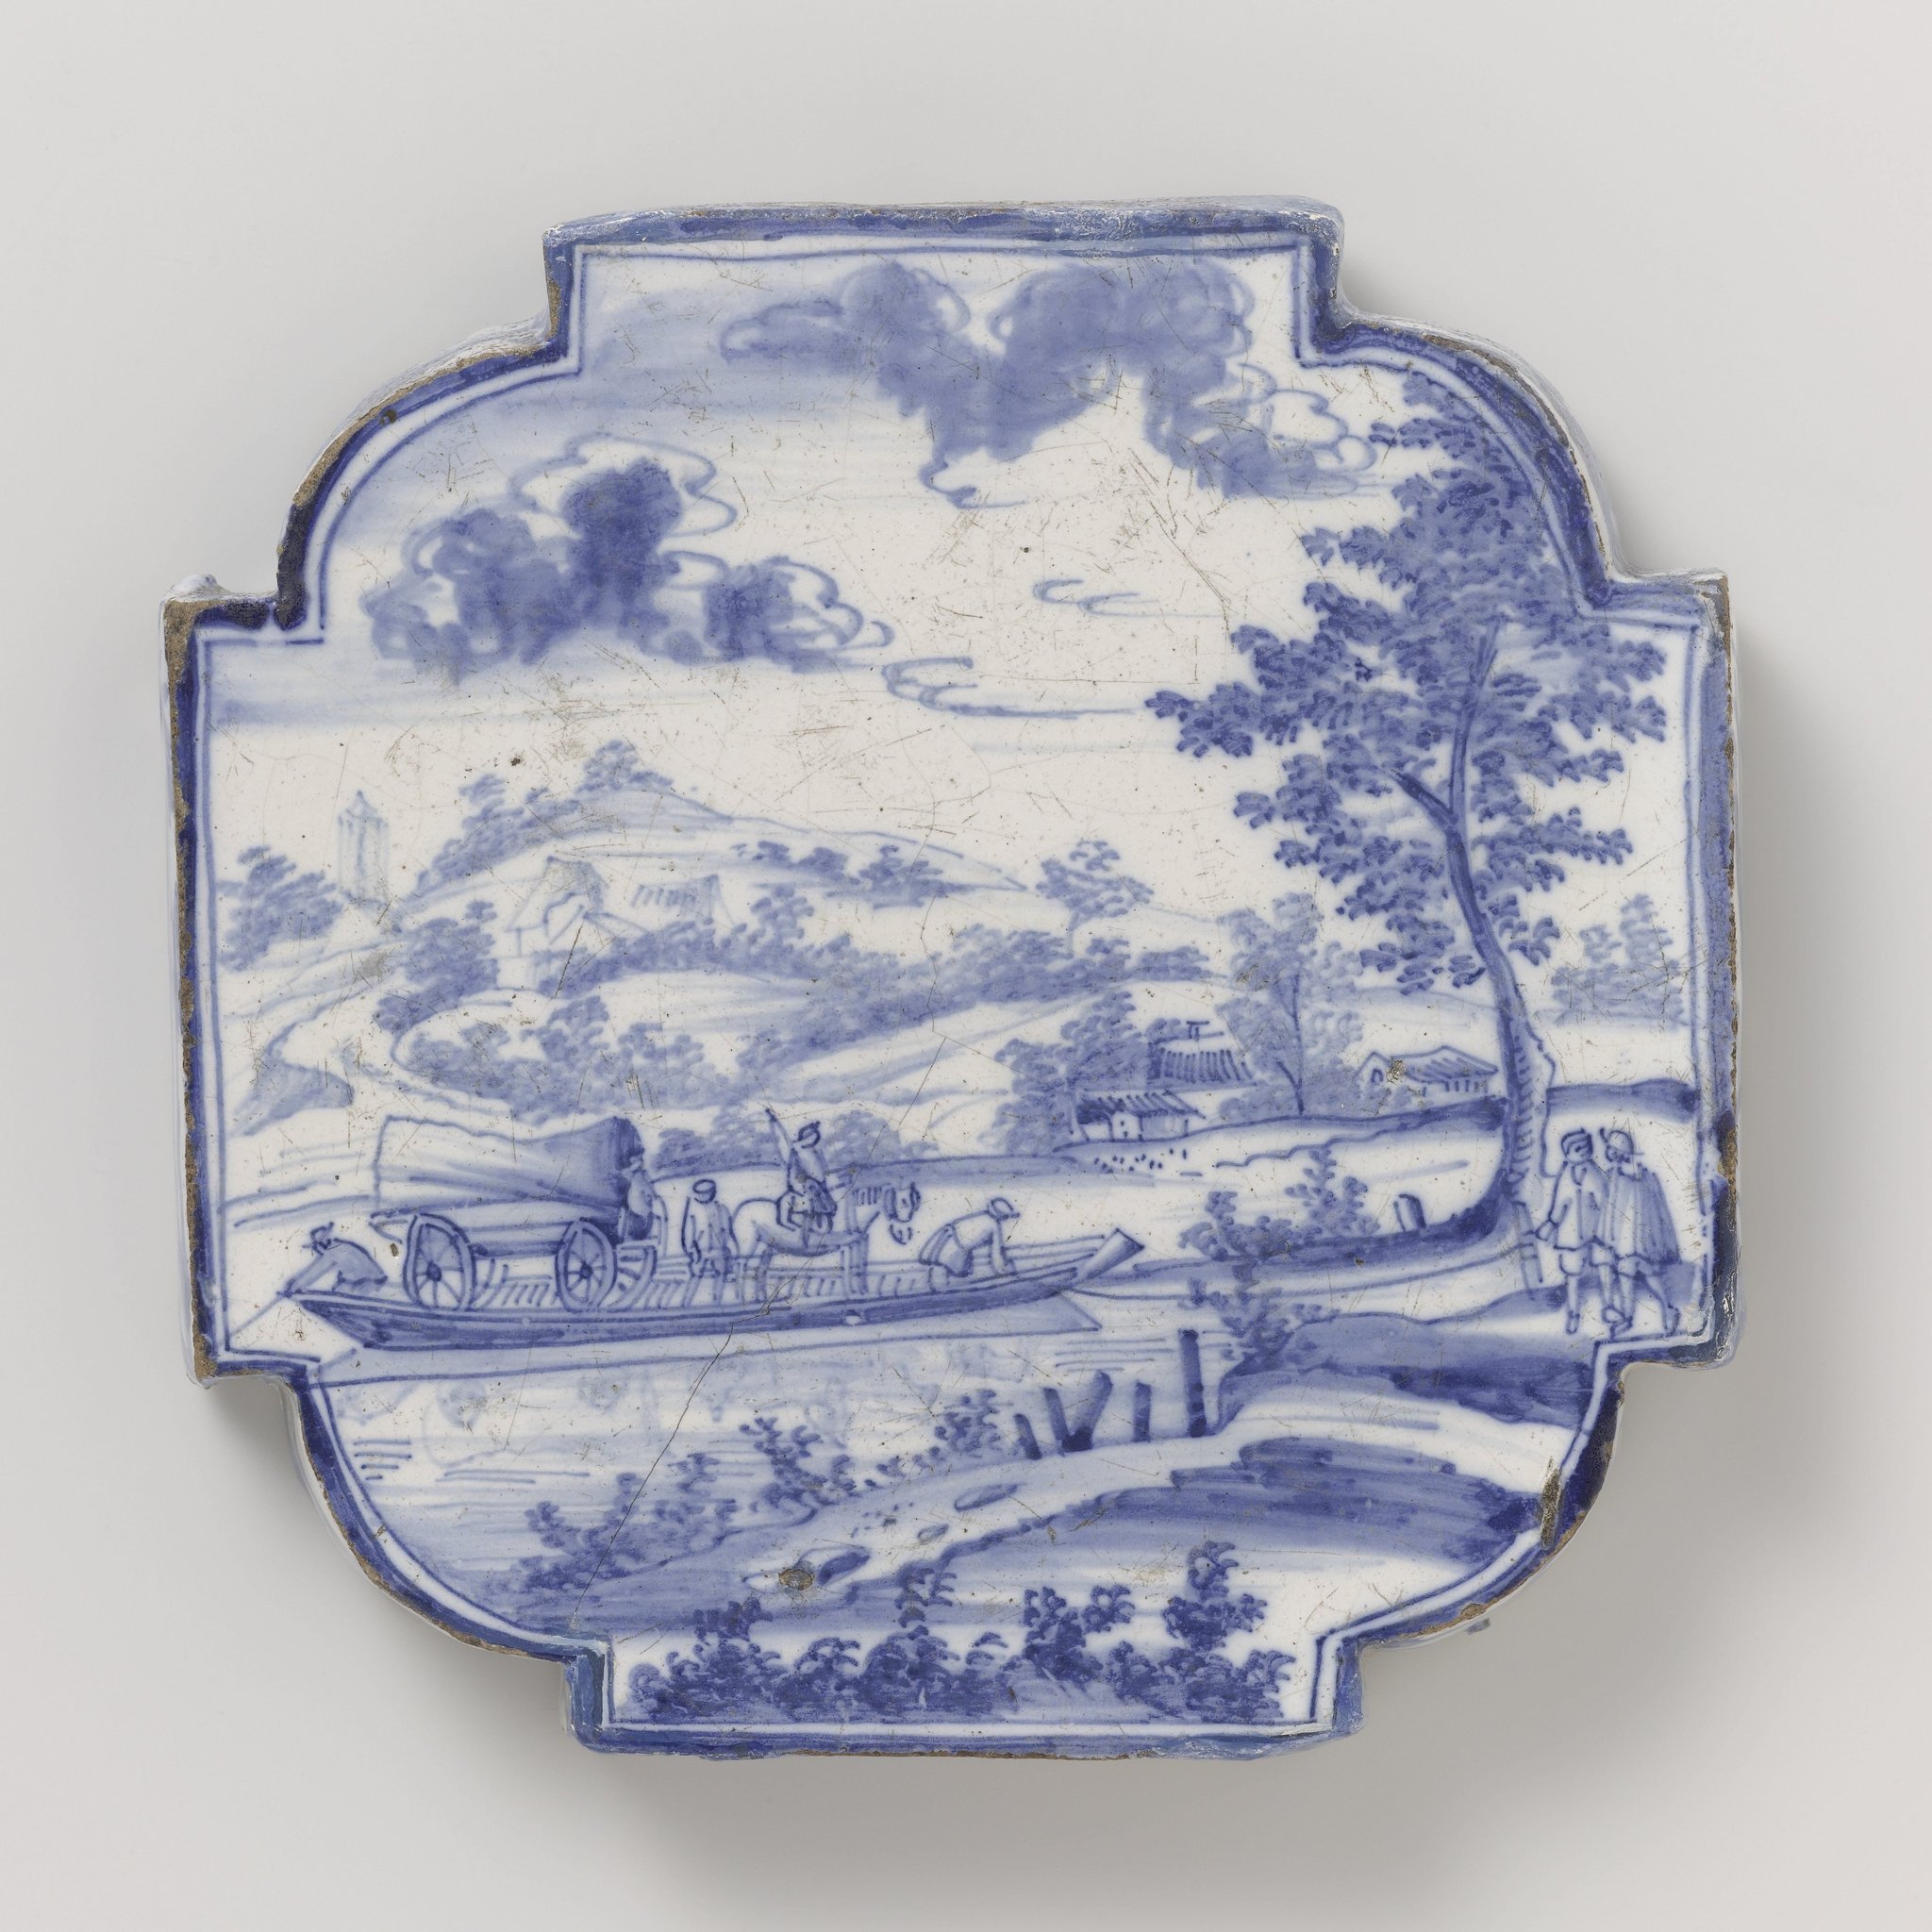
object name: plate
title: Stand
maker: Anonymous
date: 1735-1745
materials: faience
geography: amsterdam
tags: river, ferry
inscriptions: mark: ‘B.K.’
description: blad van faience, blauwe beschildering van een waterlandschap.